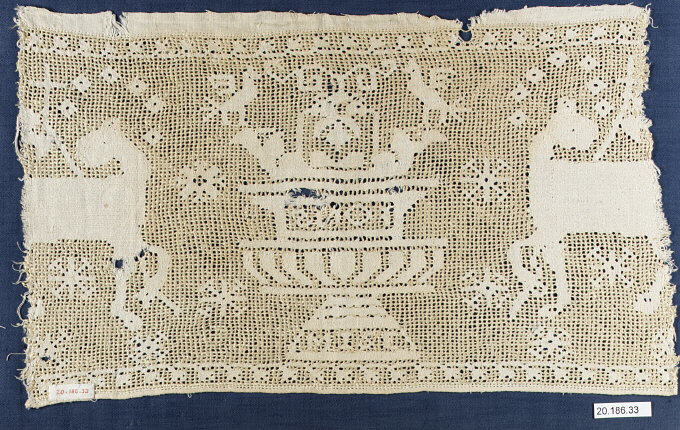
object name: border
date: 1501-1600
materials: linen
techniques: lace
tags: animals,birds